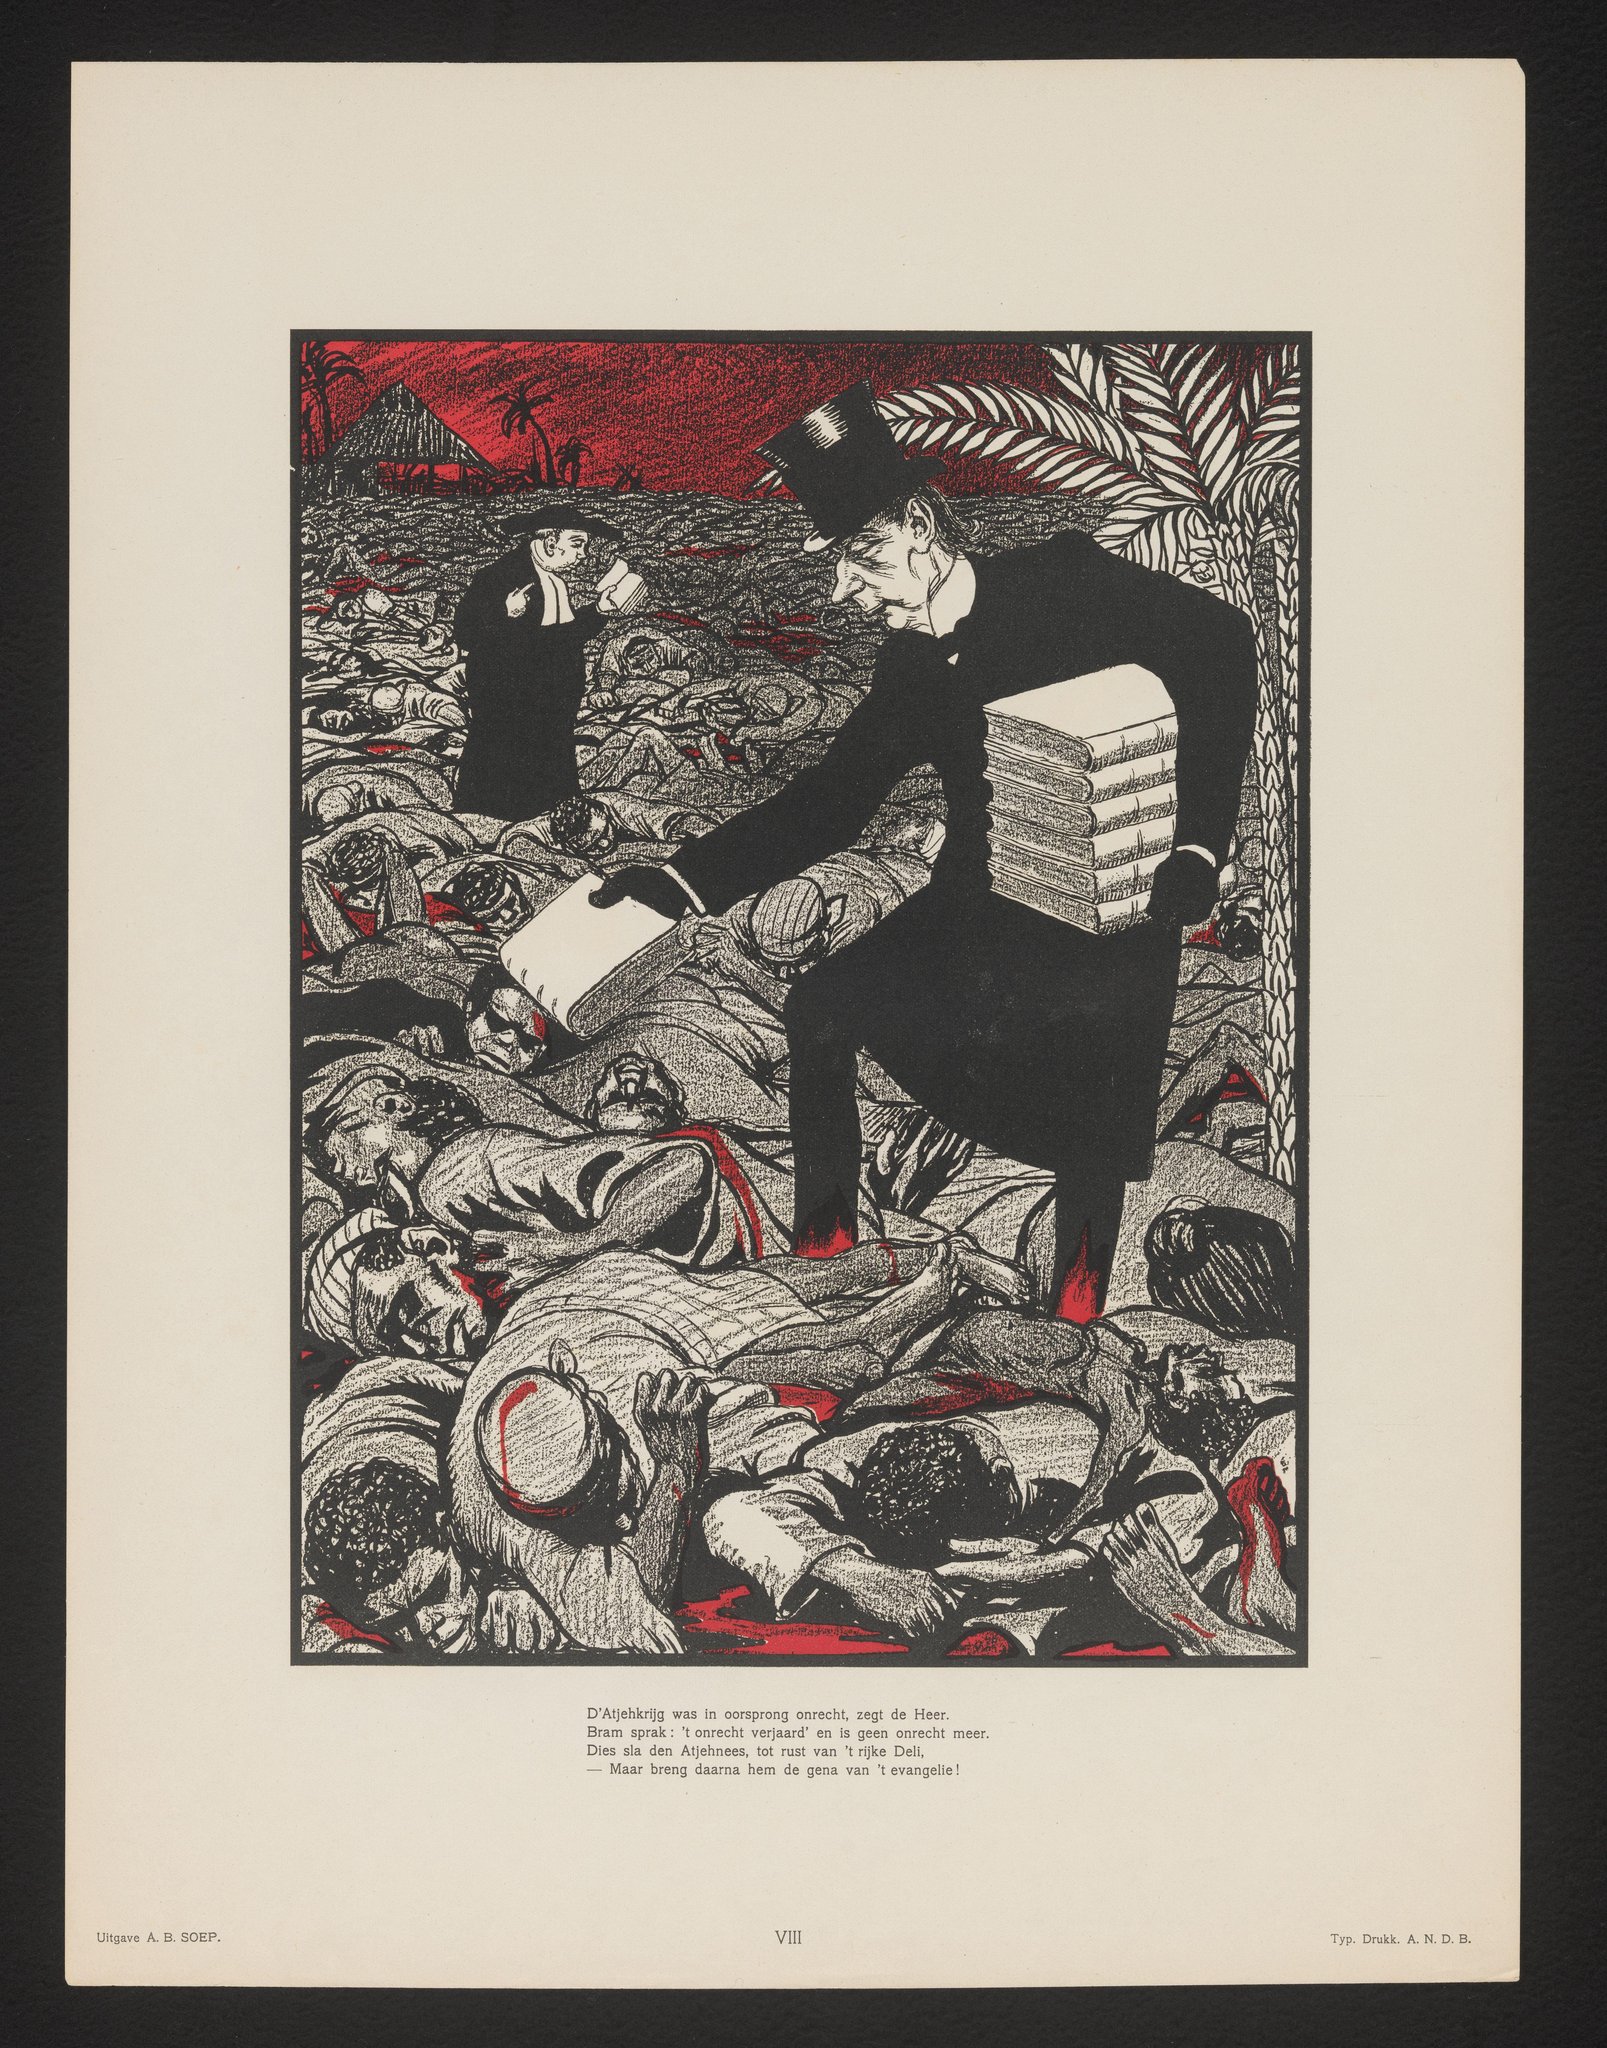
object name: cartoon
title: Onder zwart régime : 12 karikatuur-teekeningen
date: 1905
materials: paper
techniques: autotype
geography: amsterdam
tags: the hague, abraham kuyper, spreading the gospel; missionary work, political caricatures and satires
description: Abraham Kuyper laat als pastoor bijbels uitdelen onder de lijken van de inwoners van Atjeh. Met vierregelig onderschrift. Onderdeel van de prentserie 'Onder Zwart Regime'.